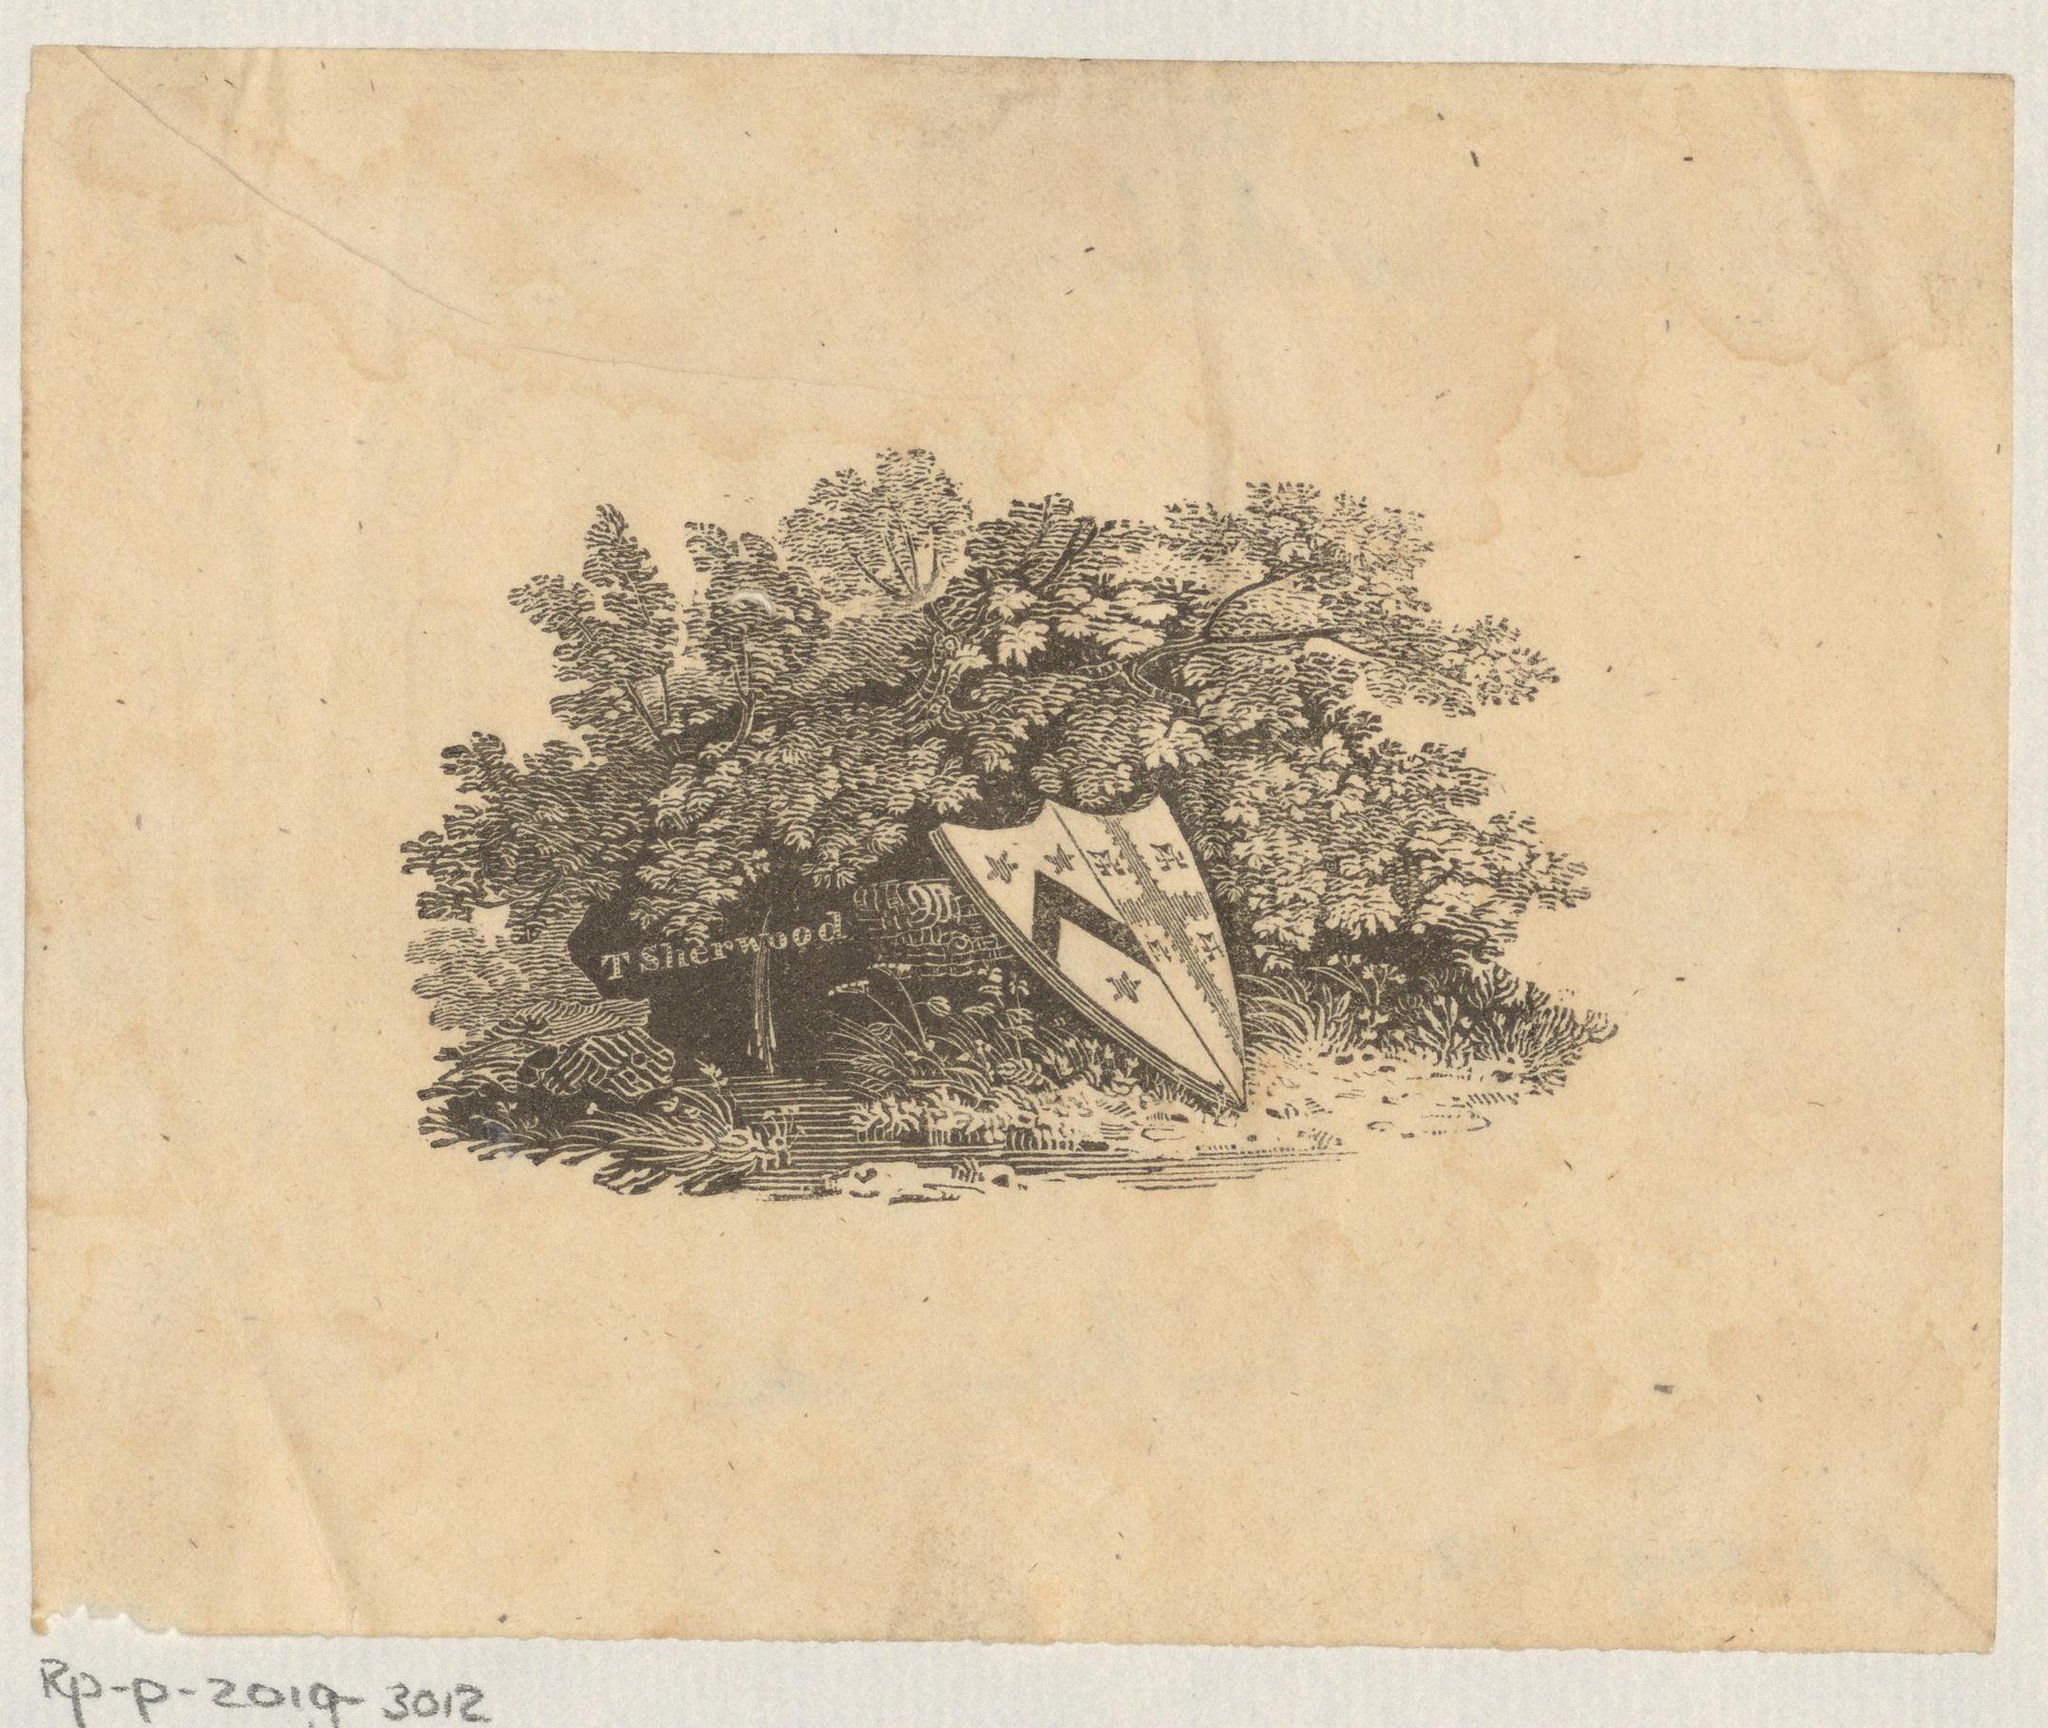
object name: bookplate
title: Ex libris van T. Sherwood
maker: thomas bewick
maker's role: draughtsman, painter, print maker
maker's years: 1753-1828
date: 1790-1828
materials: paper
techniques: engraving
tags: shrubs, armorial bearing, heraldry